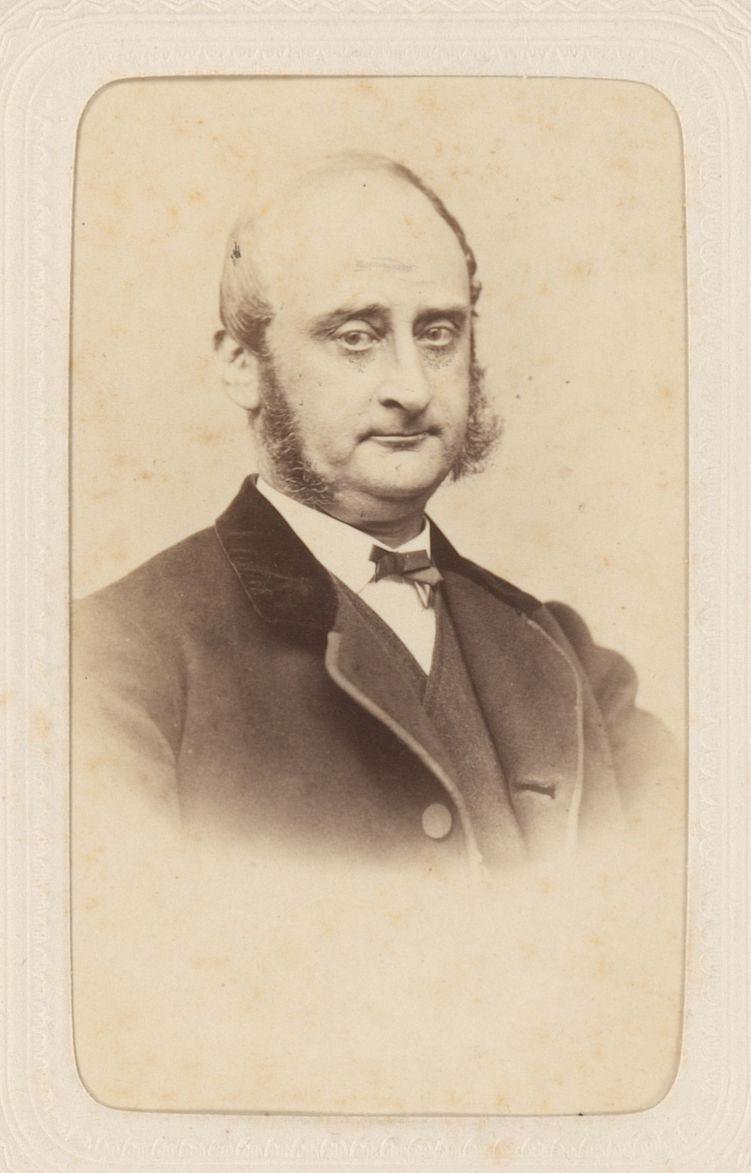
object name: carte de visite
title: Studioportret van een man met grote bakkebaarden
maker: victor alexandre georges de lapersonne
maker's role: fotograaf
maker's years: 1844-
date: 1863-1866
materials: cardboard, paper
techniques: albumen print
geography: utrecht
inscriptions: name: ‘L.C. van Geruthenar’